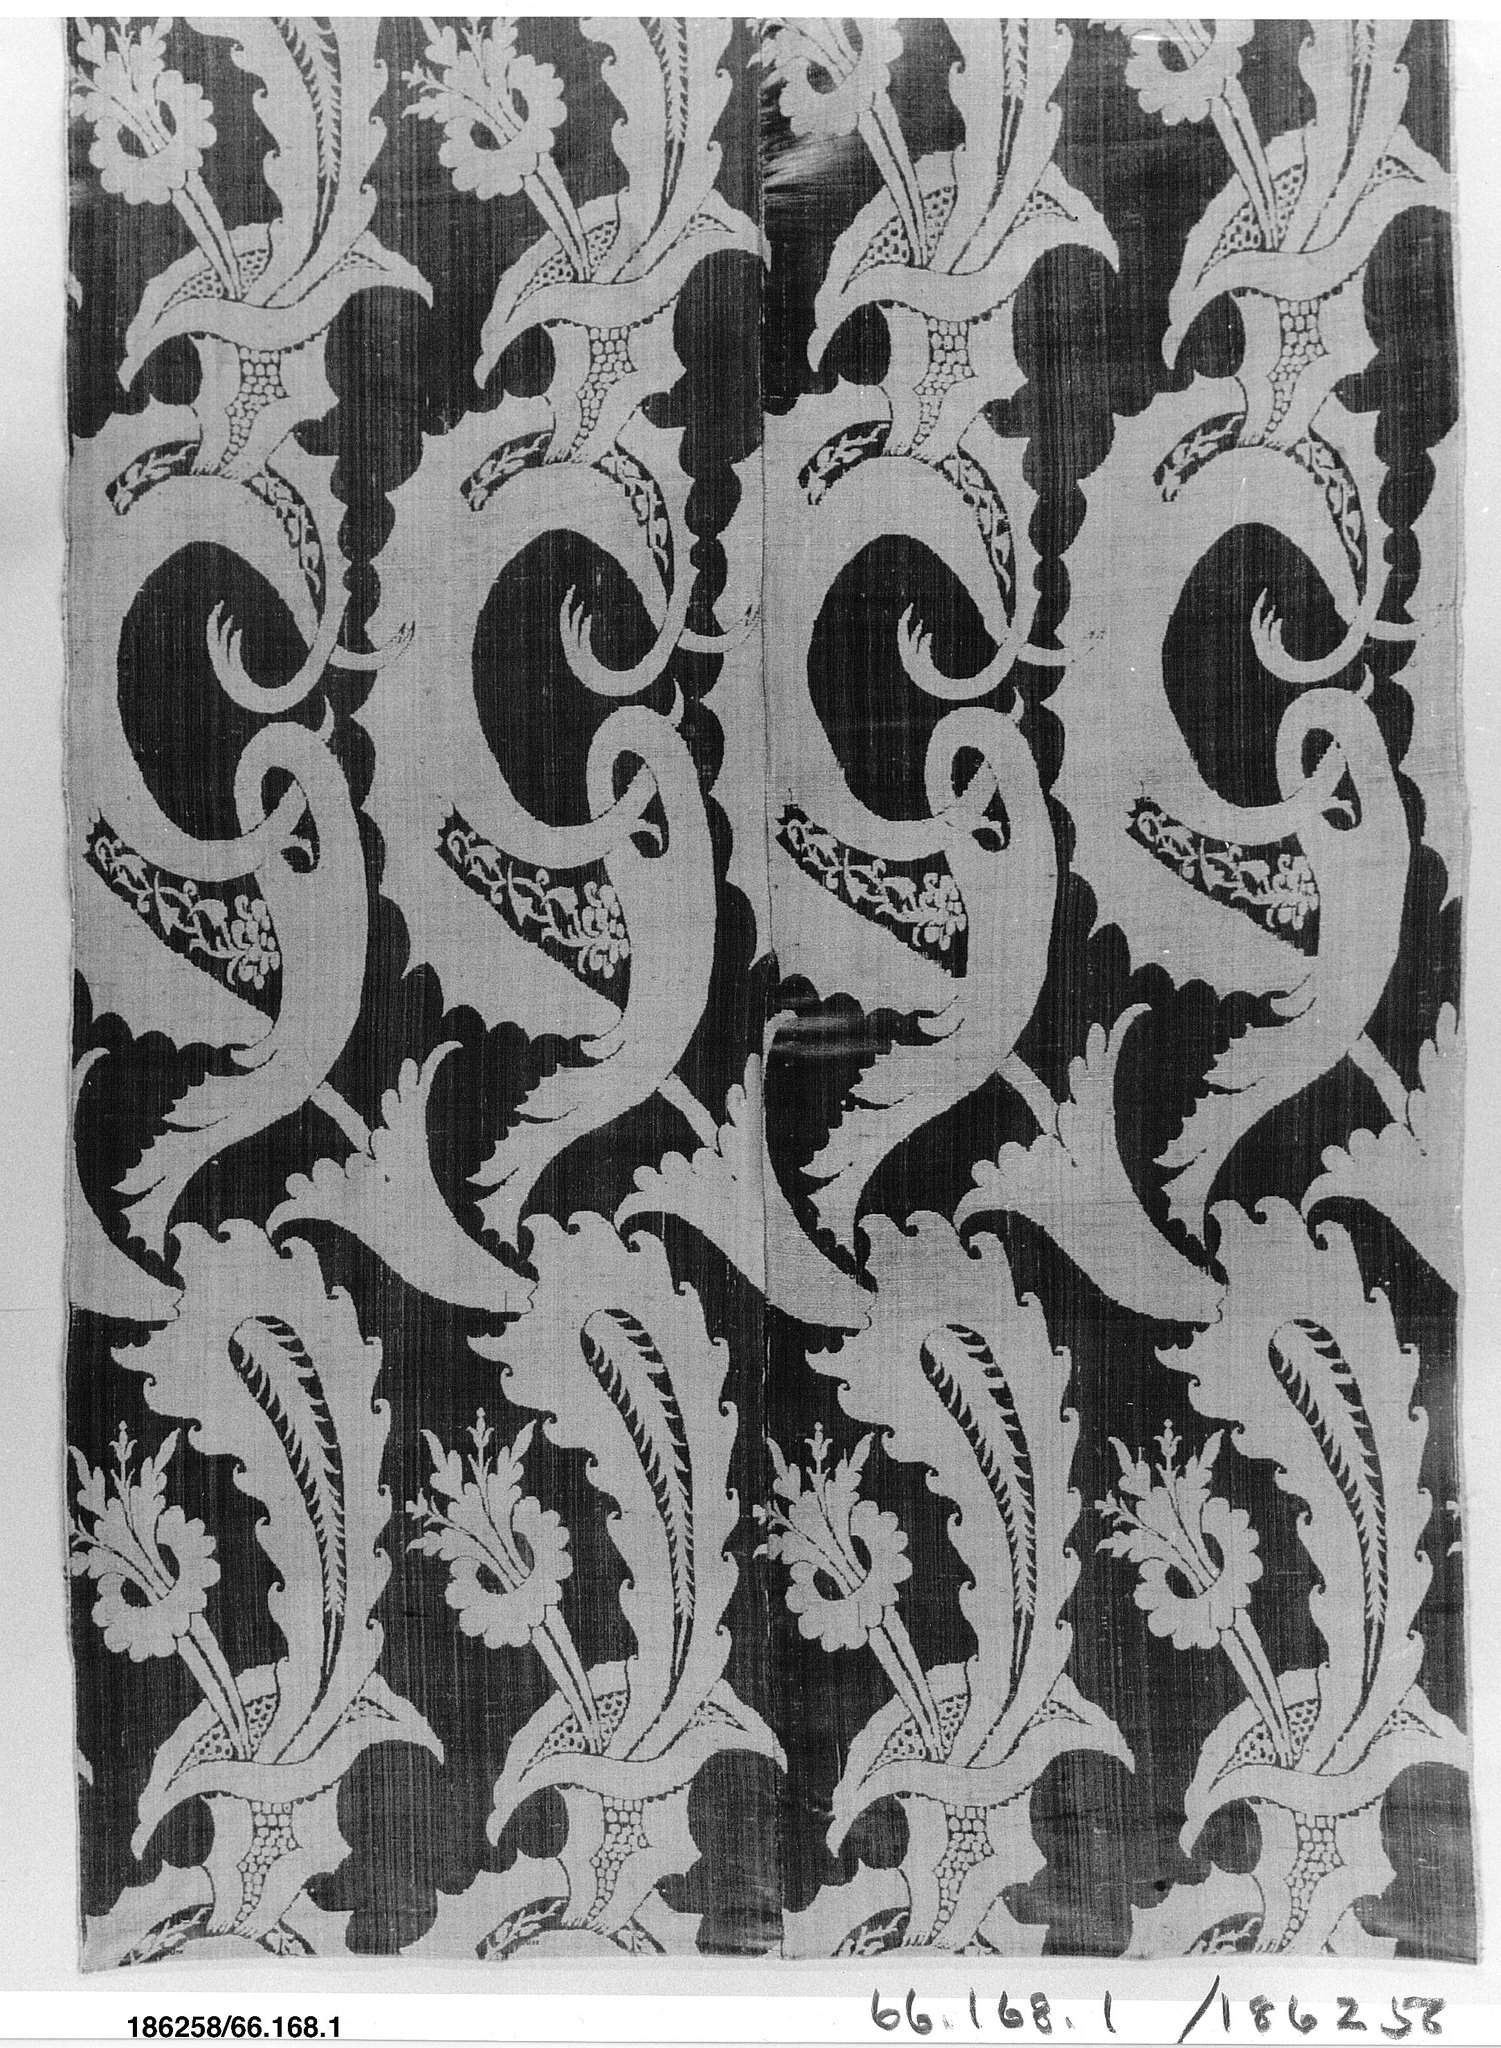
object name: panel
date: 1701-1725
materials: silk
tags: flowers